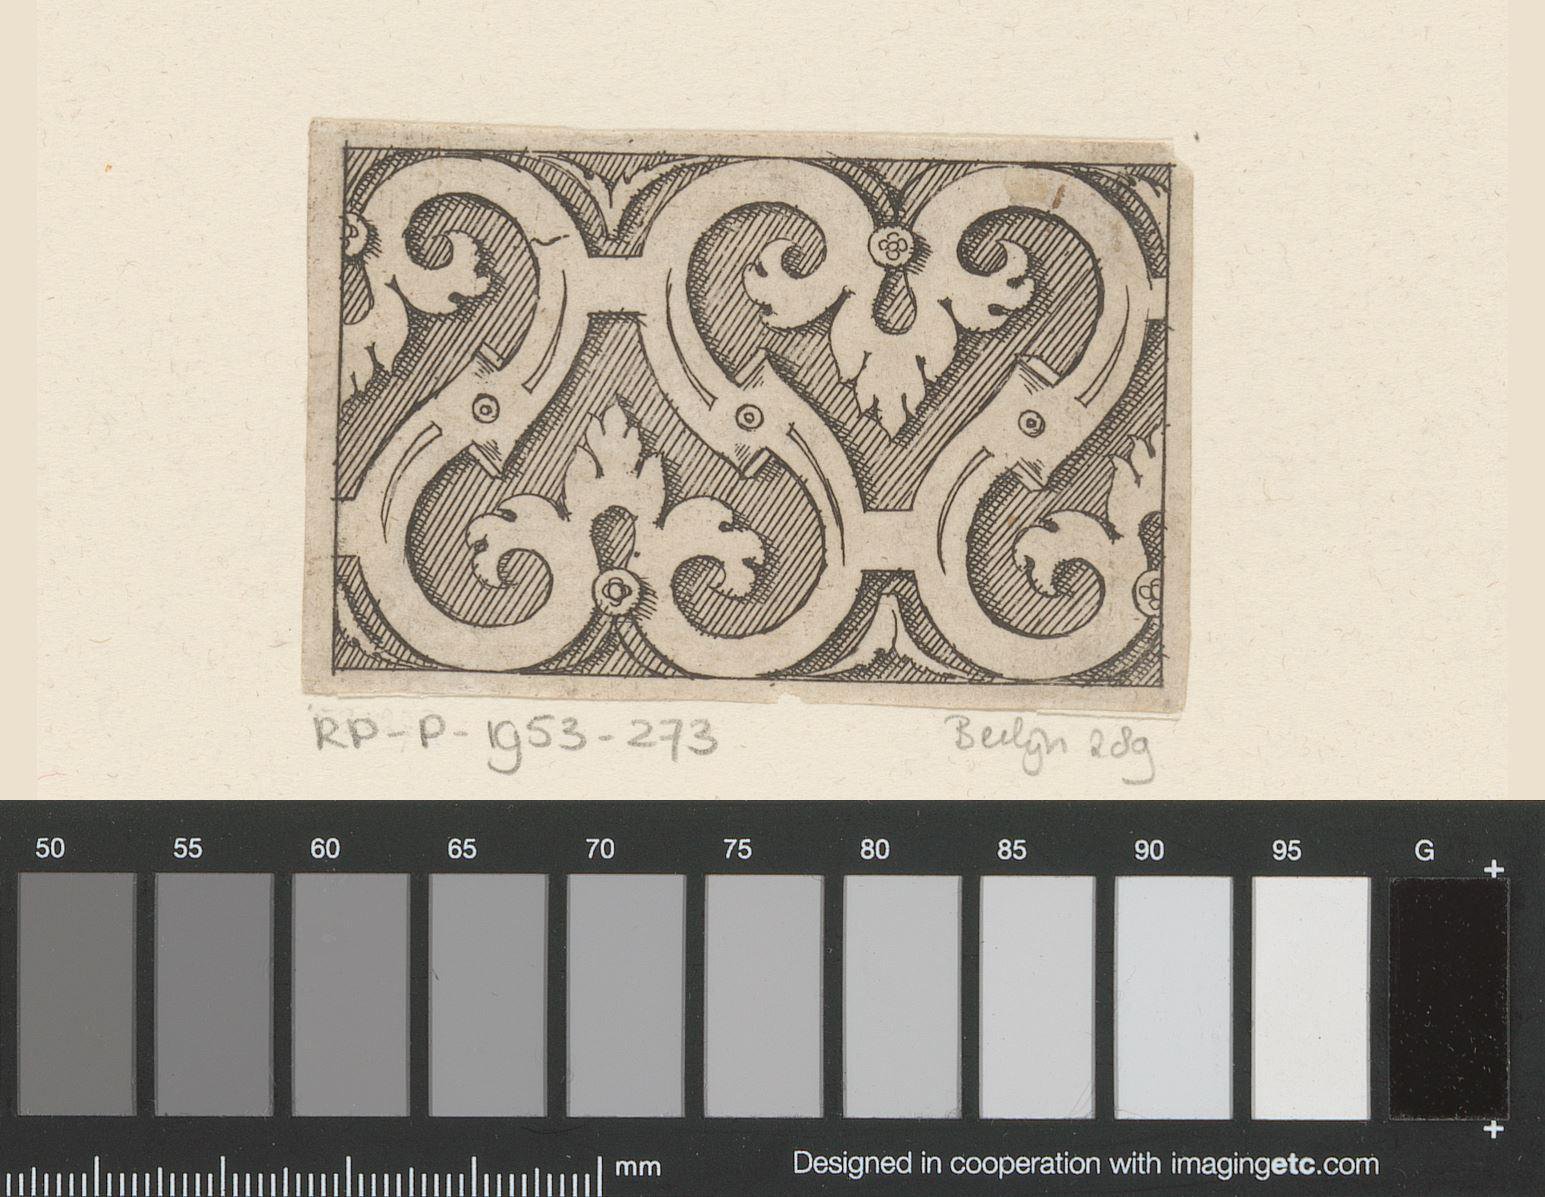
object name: ornament print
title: Vlechtwerk in hartvorm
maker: jacques androuet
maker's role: draughtsman, print maker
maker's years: 1515-1584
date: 1520-1584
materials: paper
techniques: etching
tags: interlace ~ ornament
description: S-vormige voluten die telkens spiegelbeeldig tegen elkaar gezet zijn. De uiteinden van de voluten eindigen in een driedelig blad.